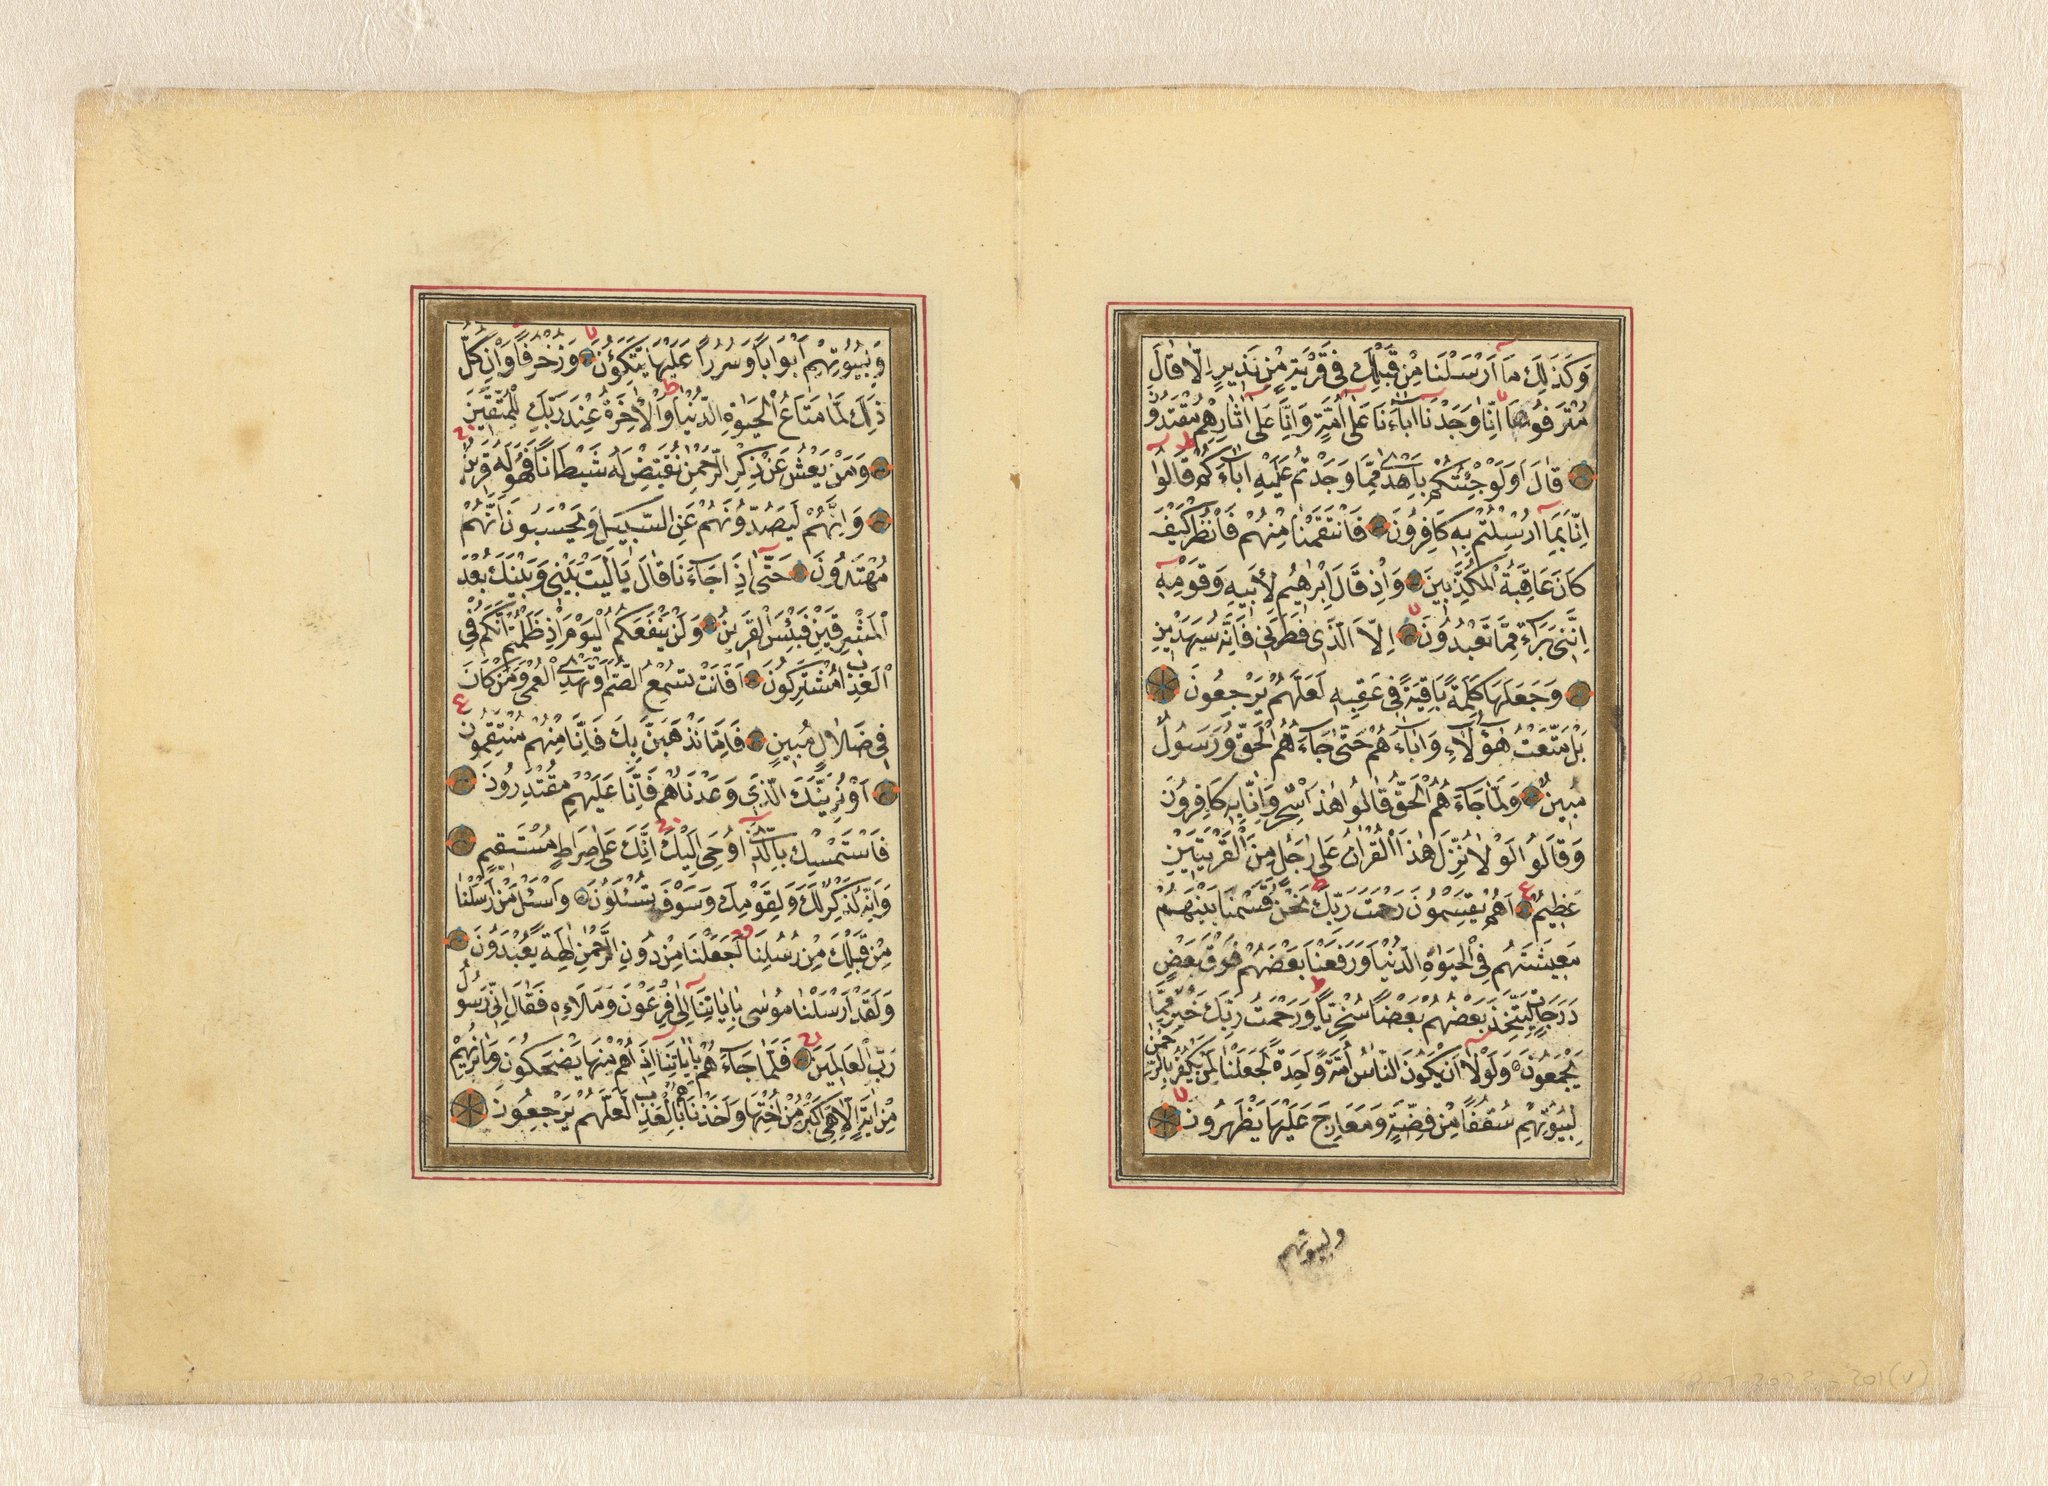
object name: persian miniature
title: Twee kalligrafische teksten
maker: Anonymous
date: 1700-1899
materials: paper, watercolor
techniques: brush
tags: calligraphy